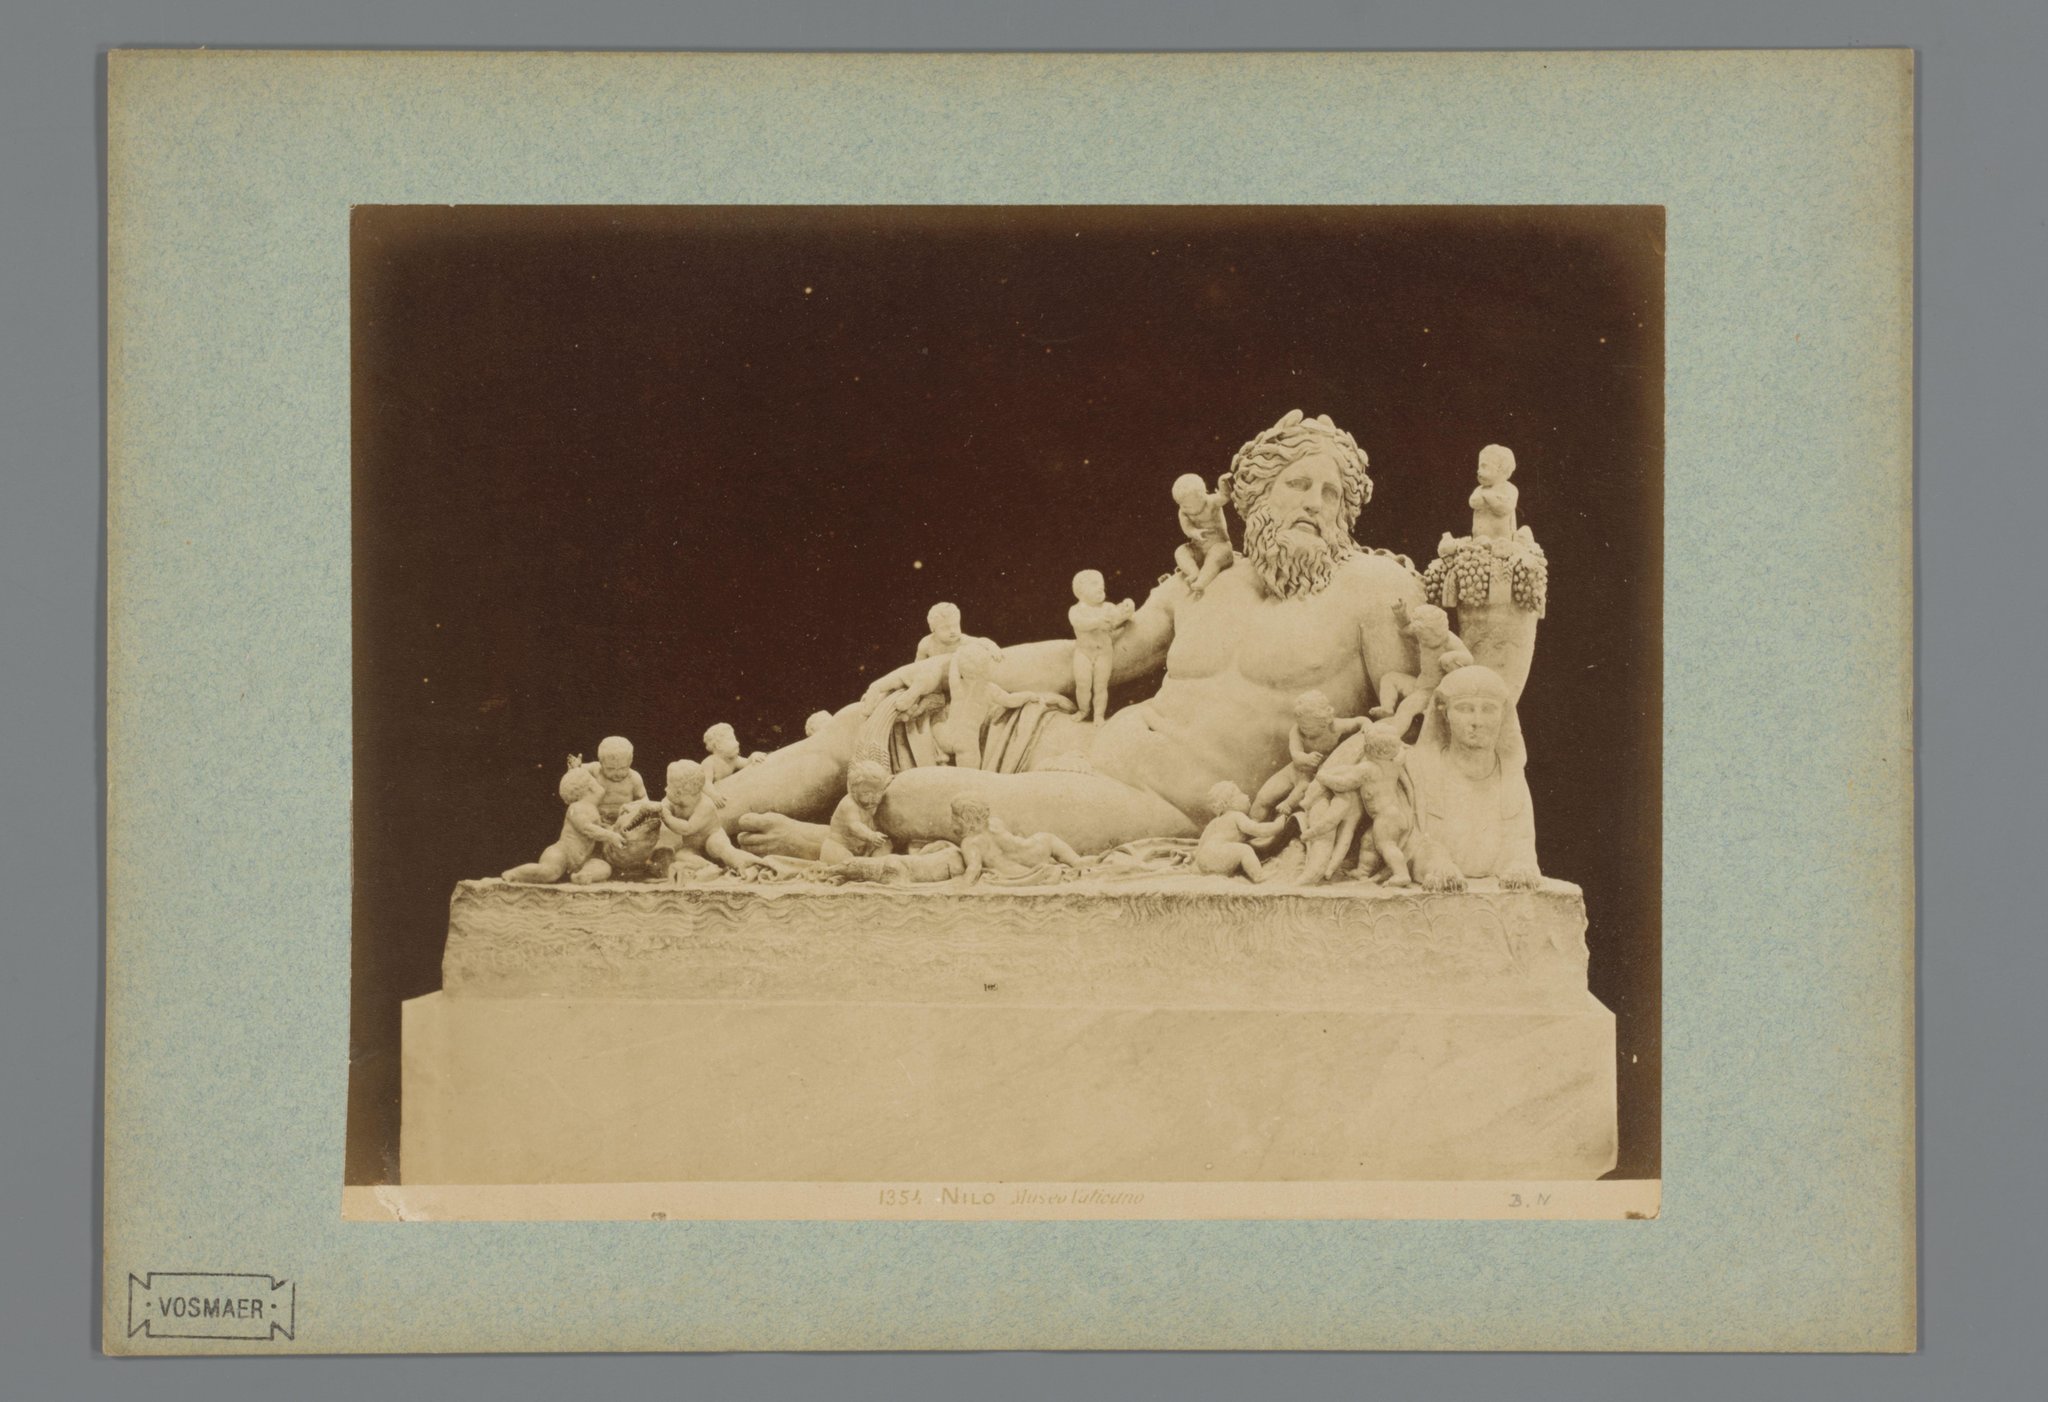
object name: photograph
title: Standbeeld van de Romeinse god van de Nijl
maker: Anonymous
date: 1851-1900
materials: cardboard, paper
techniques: albumen print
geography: vatican city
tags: monument, statue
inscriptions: inscription: ‘B.N’, number: ‘1354’, collector's mark: ‘VOSMAER’